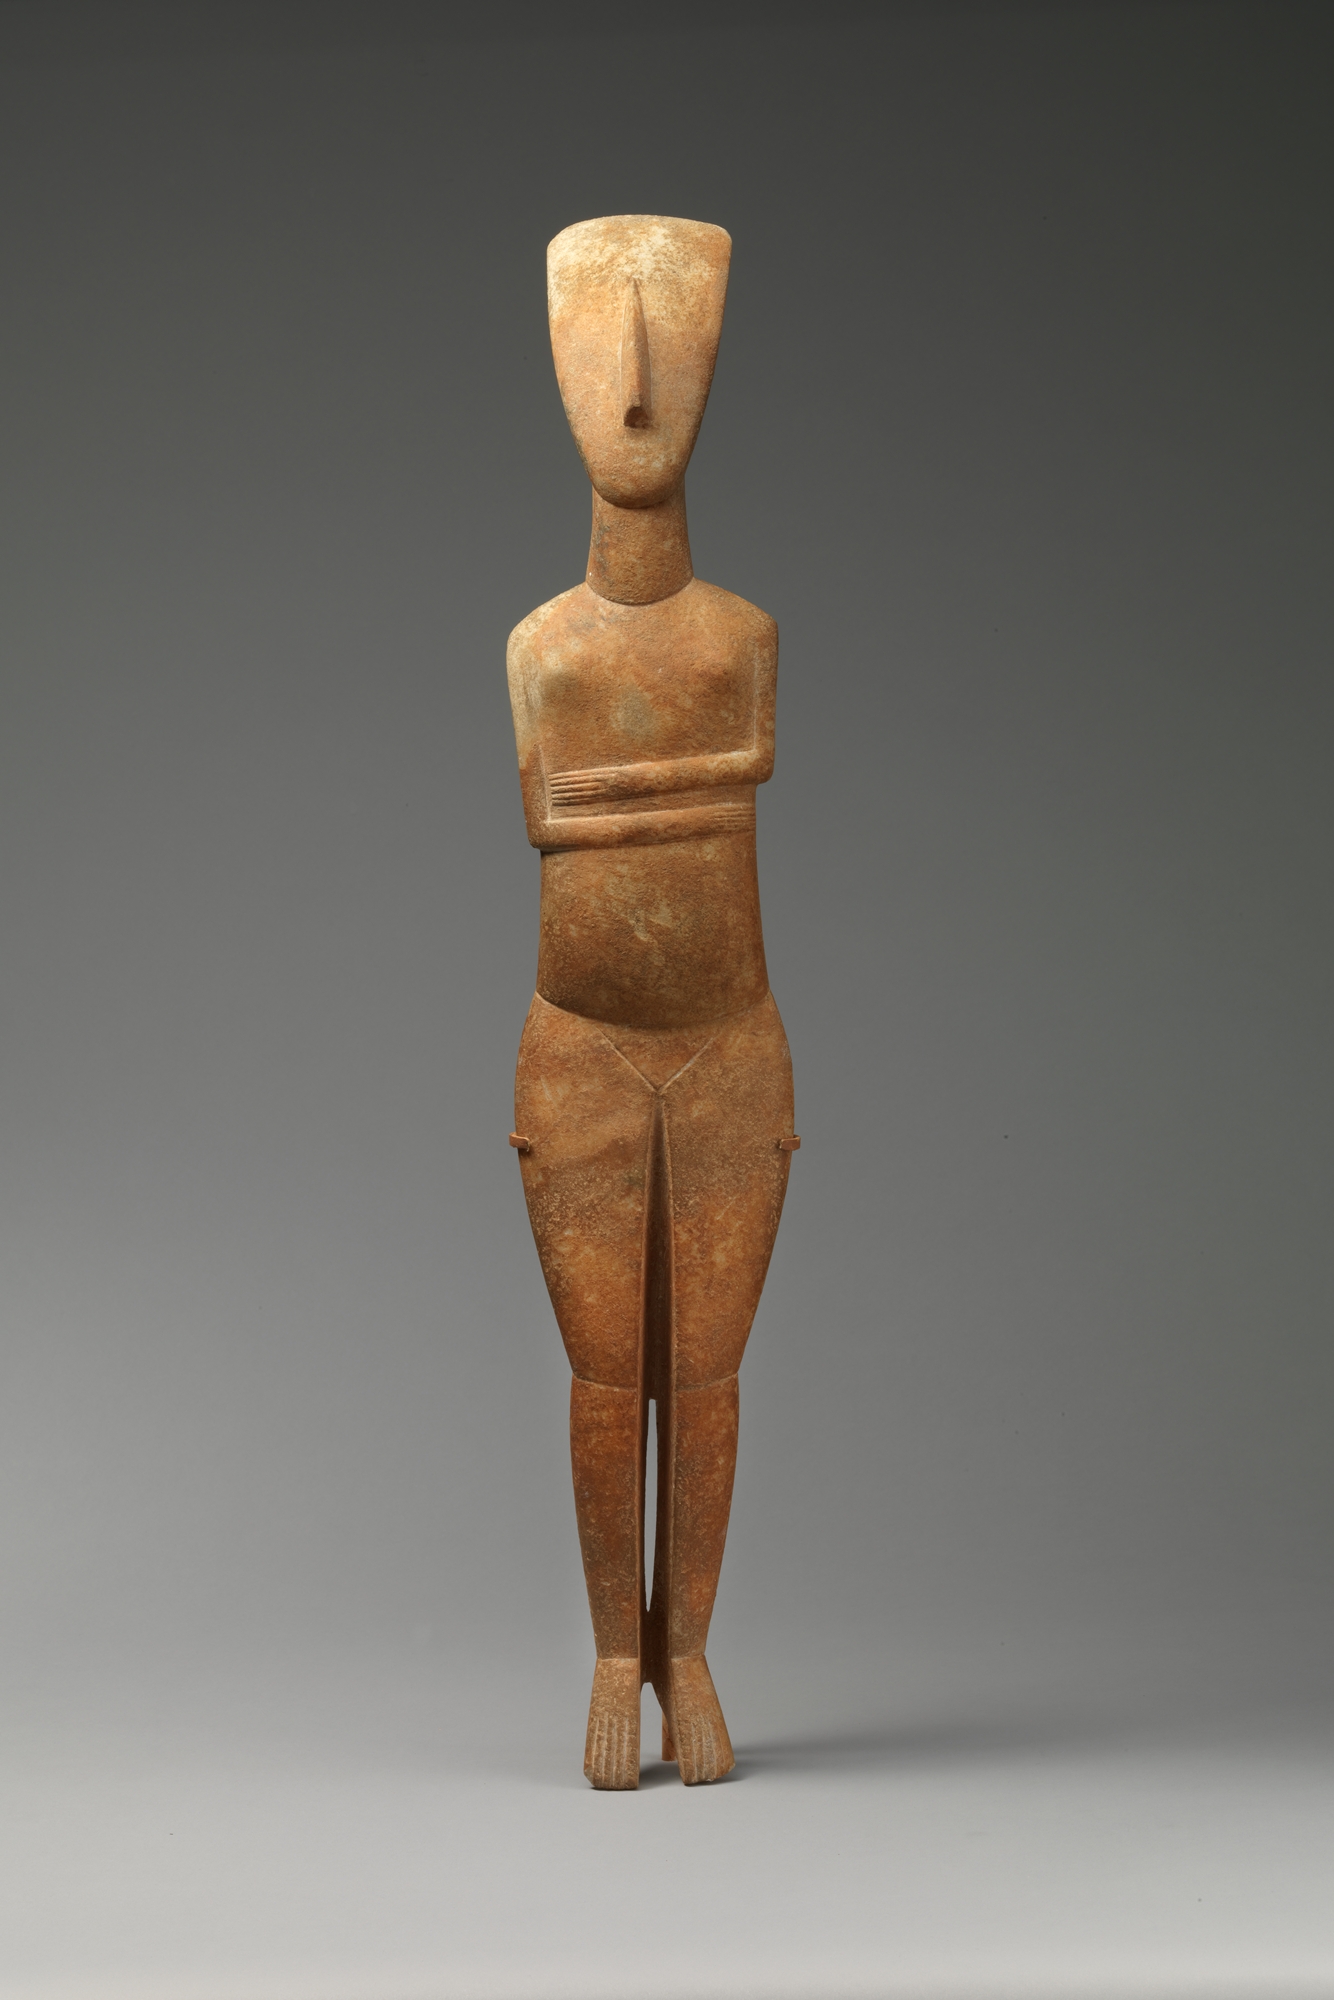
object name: statuette of a woman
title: Marble female figure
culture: cycladic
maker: bastis master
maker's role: artist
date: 2600-2400 BCE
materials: marble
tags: women